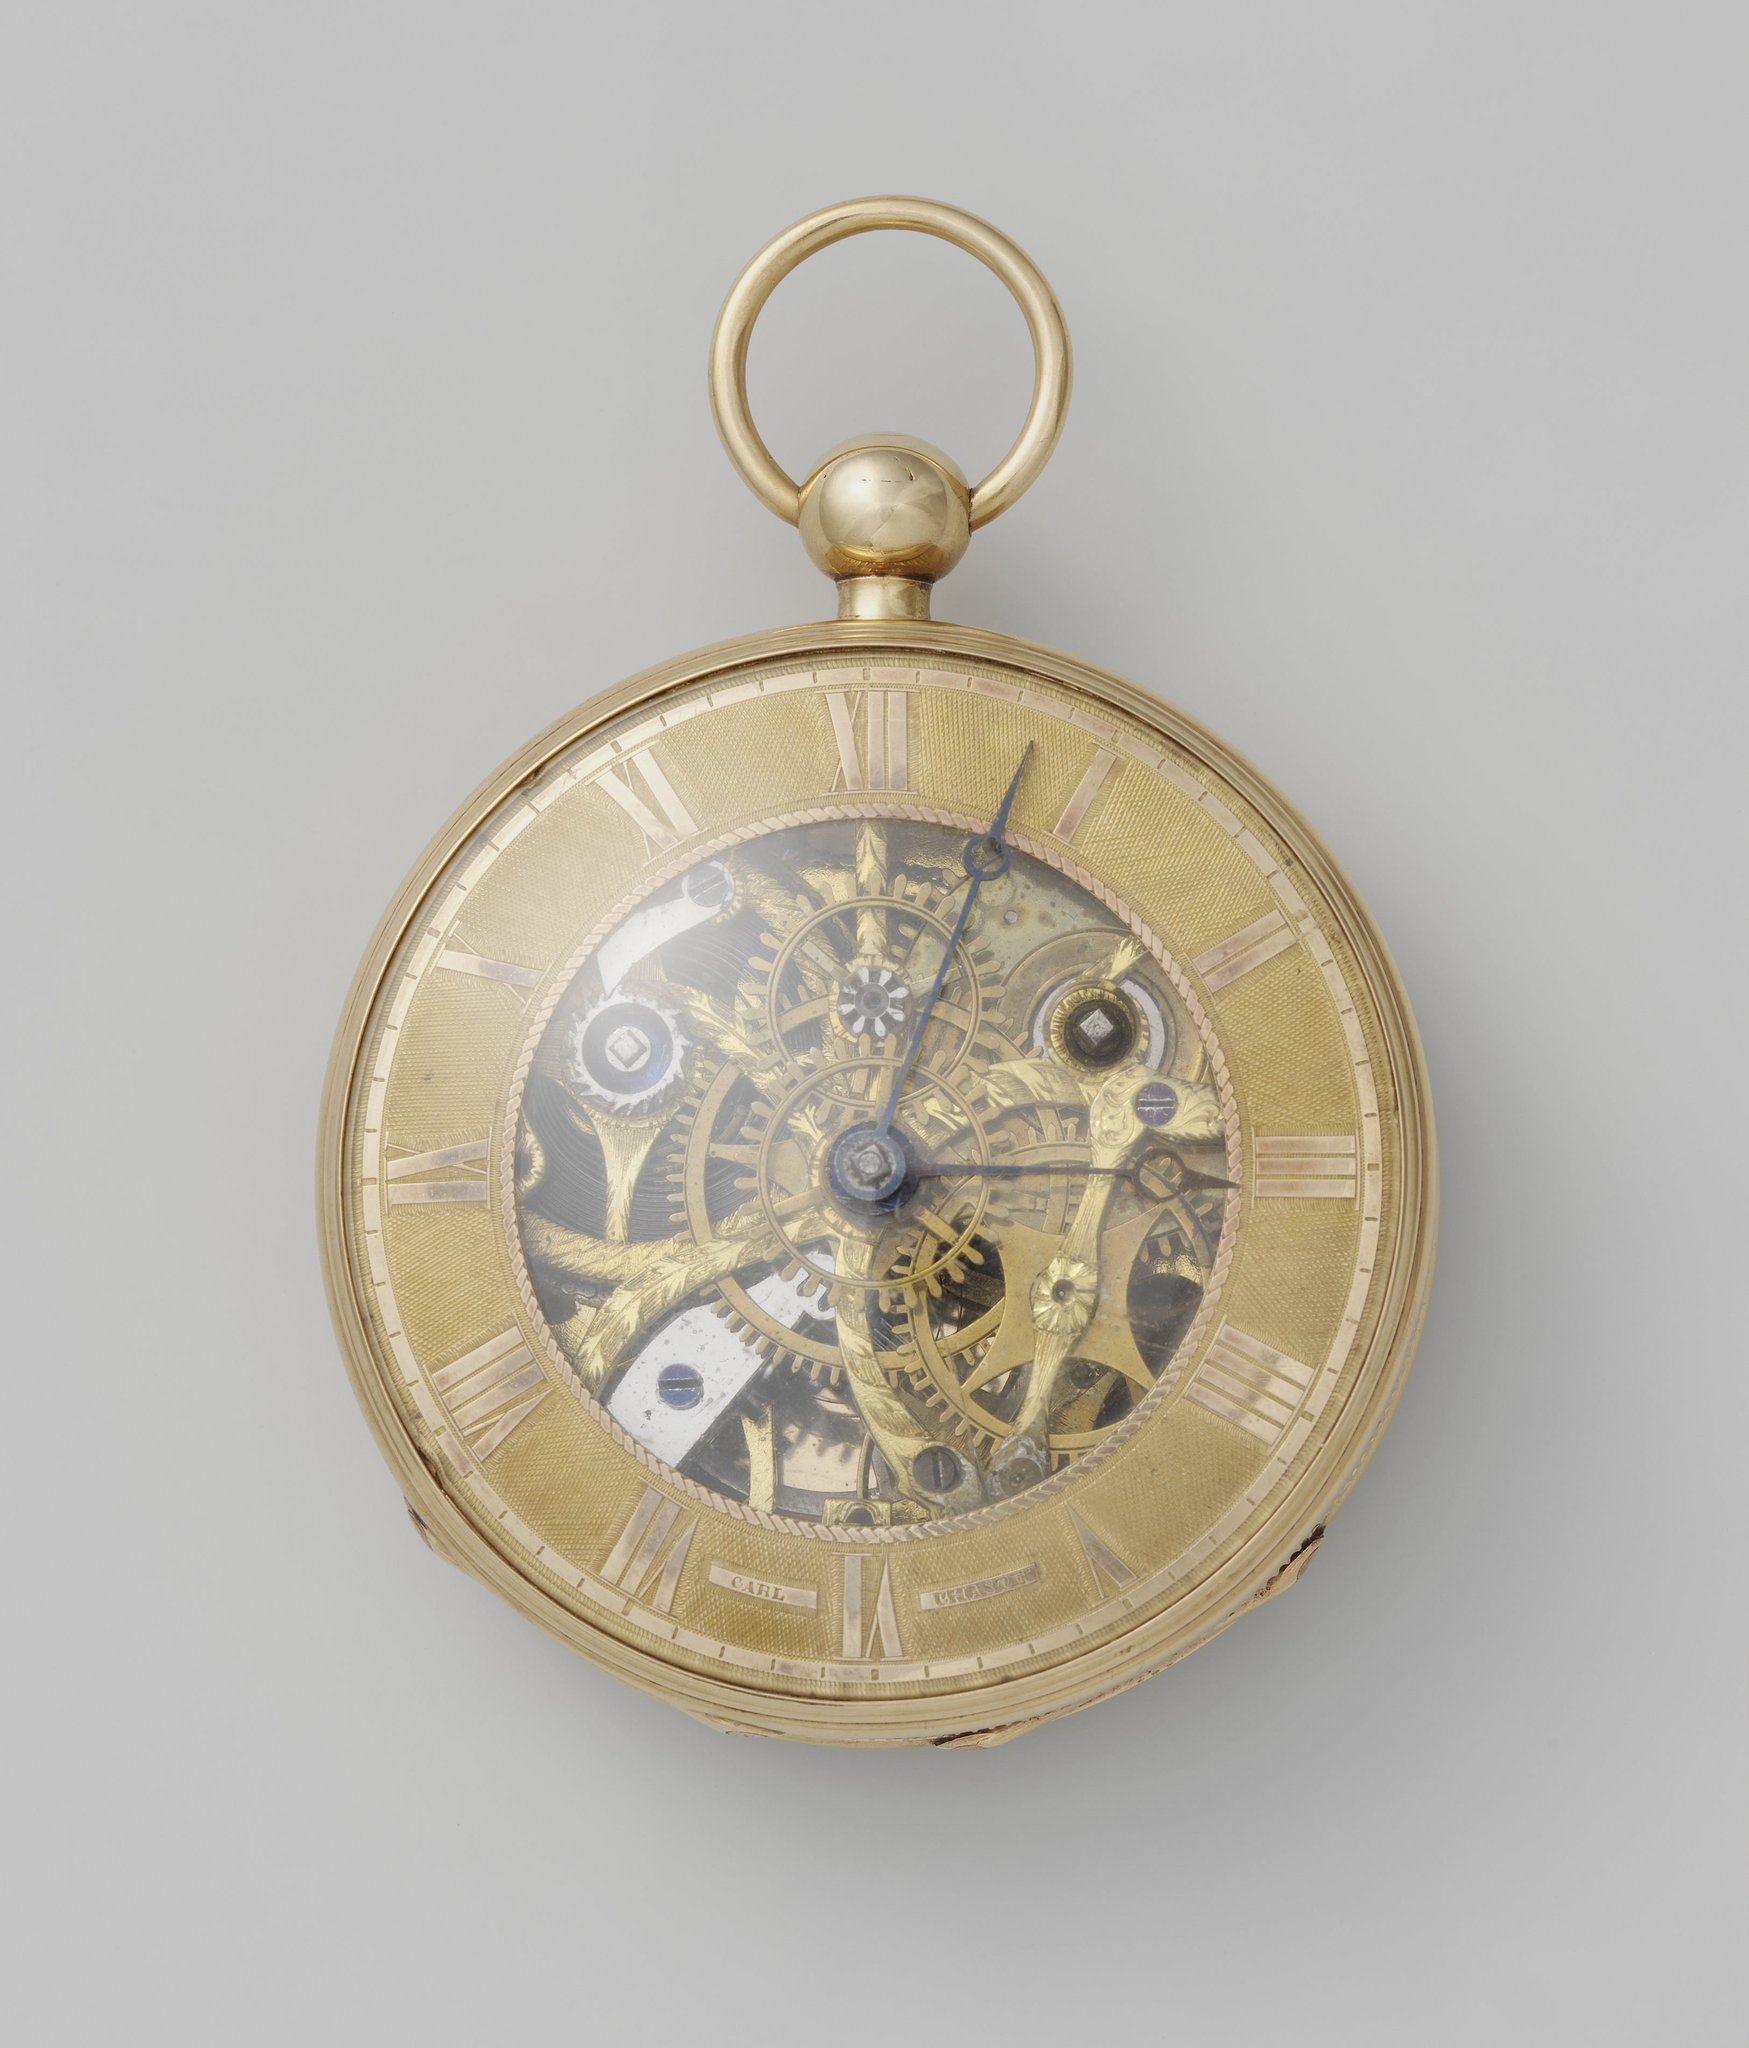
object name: jewellery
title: Watch with a Skeleton Dial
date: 1815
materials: copper, glass, gold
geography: switzerland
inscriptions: signature: ‘Carl Chasté’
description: Gouden herenhorloge, de achterbodem geheel geguillocheerd met uitzondering van een kleine cirkel. De carure is geribd. De wijzerplaat met gearceerde cijferring met gouden Romeinse uurcijfers heeft een cirkelvormige opening waardoor het radarwerk zichtbaar is evenals aan de onderzijde, waar de platine vervangen is door glas. Gemerkt op de koperen rand: Carl Chasté.